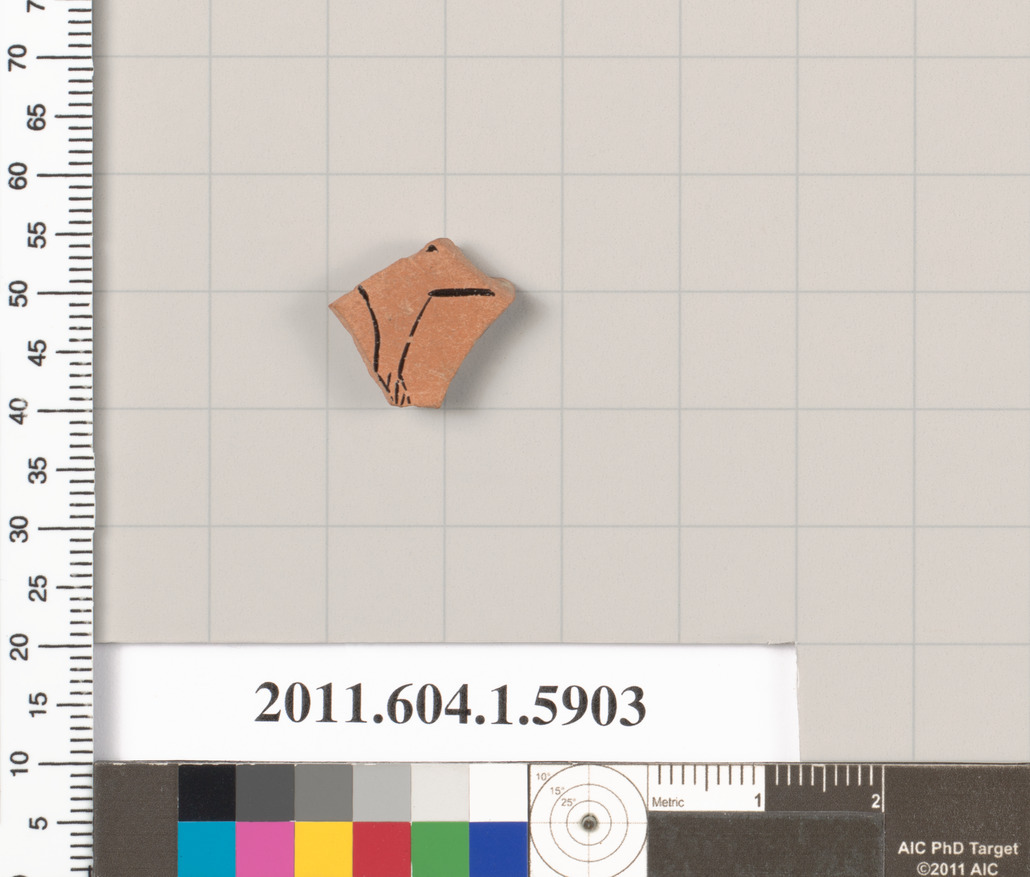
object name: kylix fragment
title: Terracotta fragment of a kylix (drinking cup)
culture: greek, attic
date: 520-510 BCE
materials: terracotta